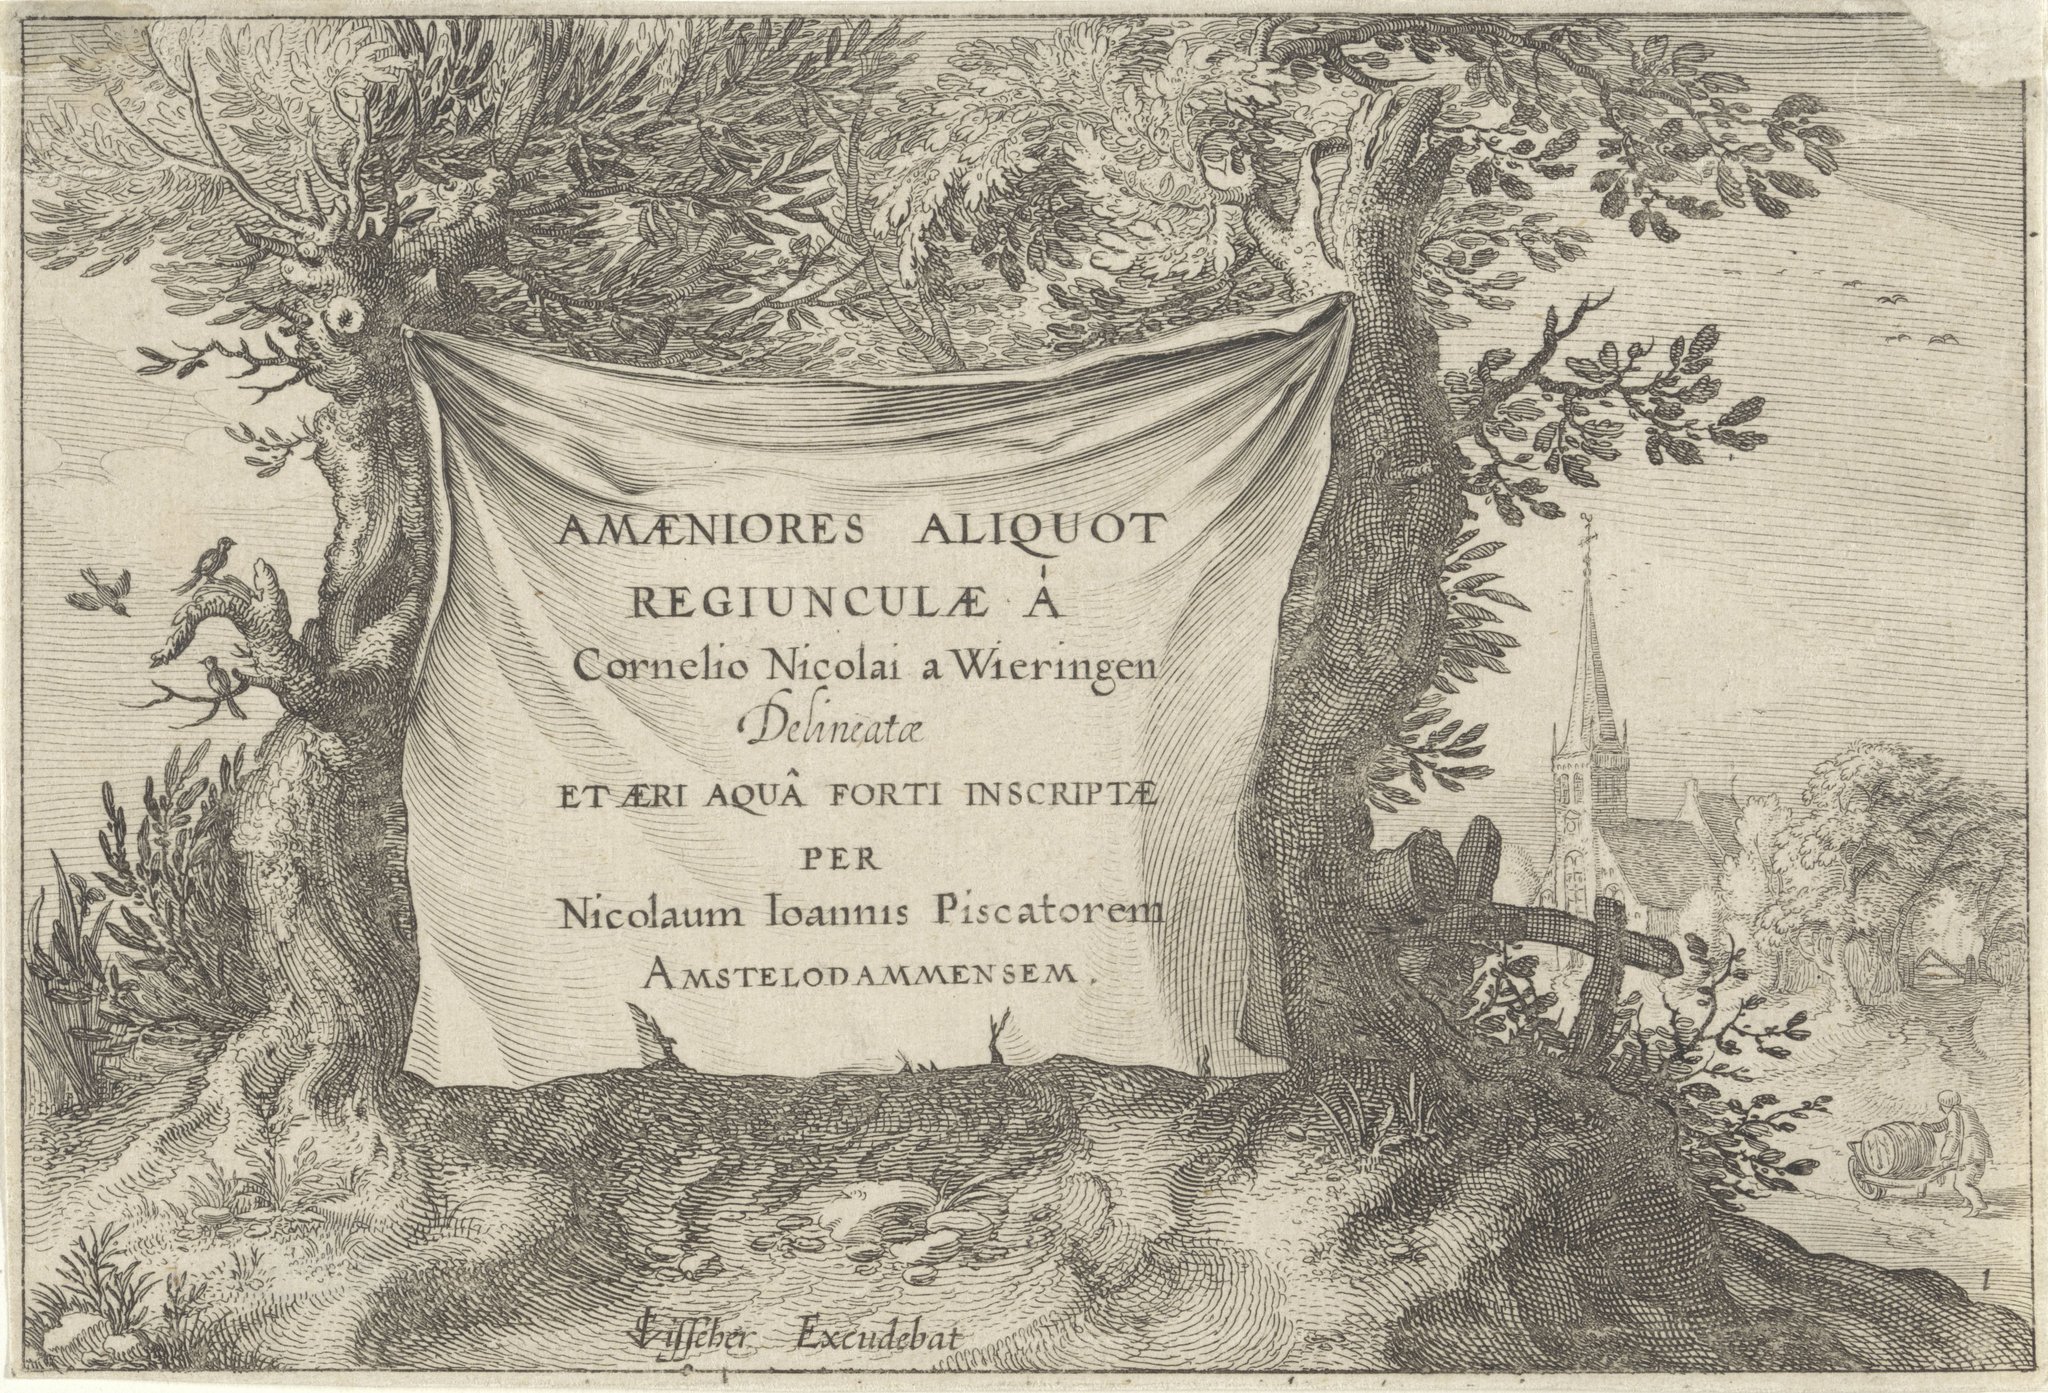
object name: titelprent, frontispice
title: Hollandse landschappen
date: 1612-1613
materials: paper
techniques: engraving, etching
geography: amsterdam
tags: trees, landscapes, title-page, church (exterior)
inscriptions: number: ‘1’, collector's mark: Lugt 2228, title: ‘Amaeniores Aliquot / Regiunculae a / Cornelio Nicolai a Wieringen / Delineate / et aeri aqua forti inscriptae / per / Nicolaum Ioannis Piscatorem / Amstelodammensem’, address: ‘CIVisscher Excudebat’, date: ‘1613’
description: Tussen twee bomen is een witte lap opgespannen, waarop de titel van de serie: Amaeniores Aliquot Regiunculae. Rechtsachter op een landweg een man die een ton op een kar vervoert. Op de achtergrond een kerk.